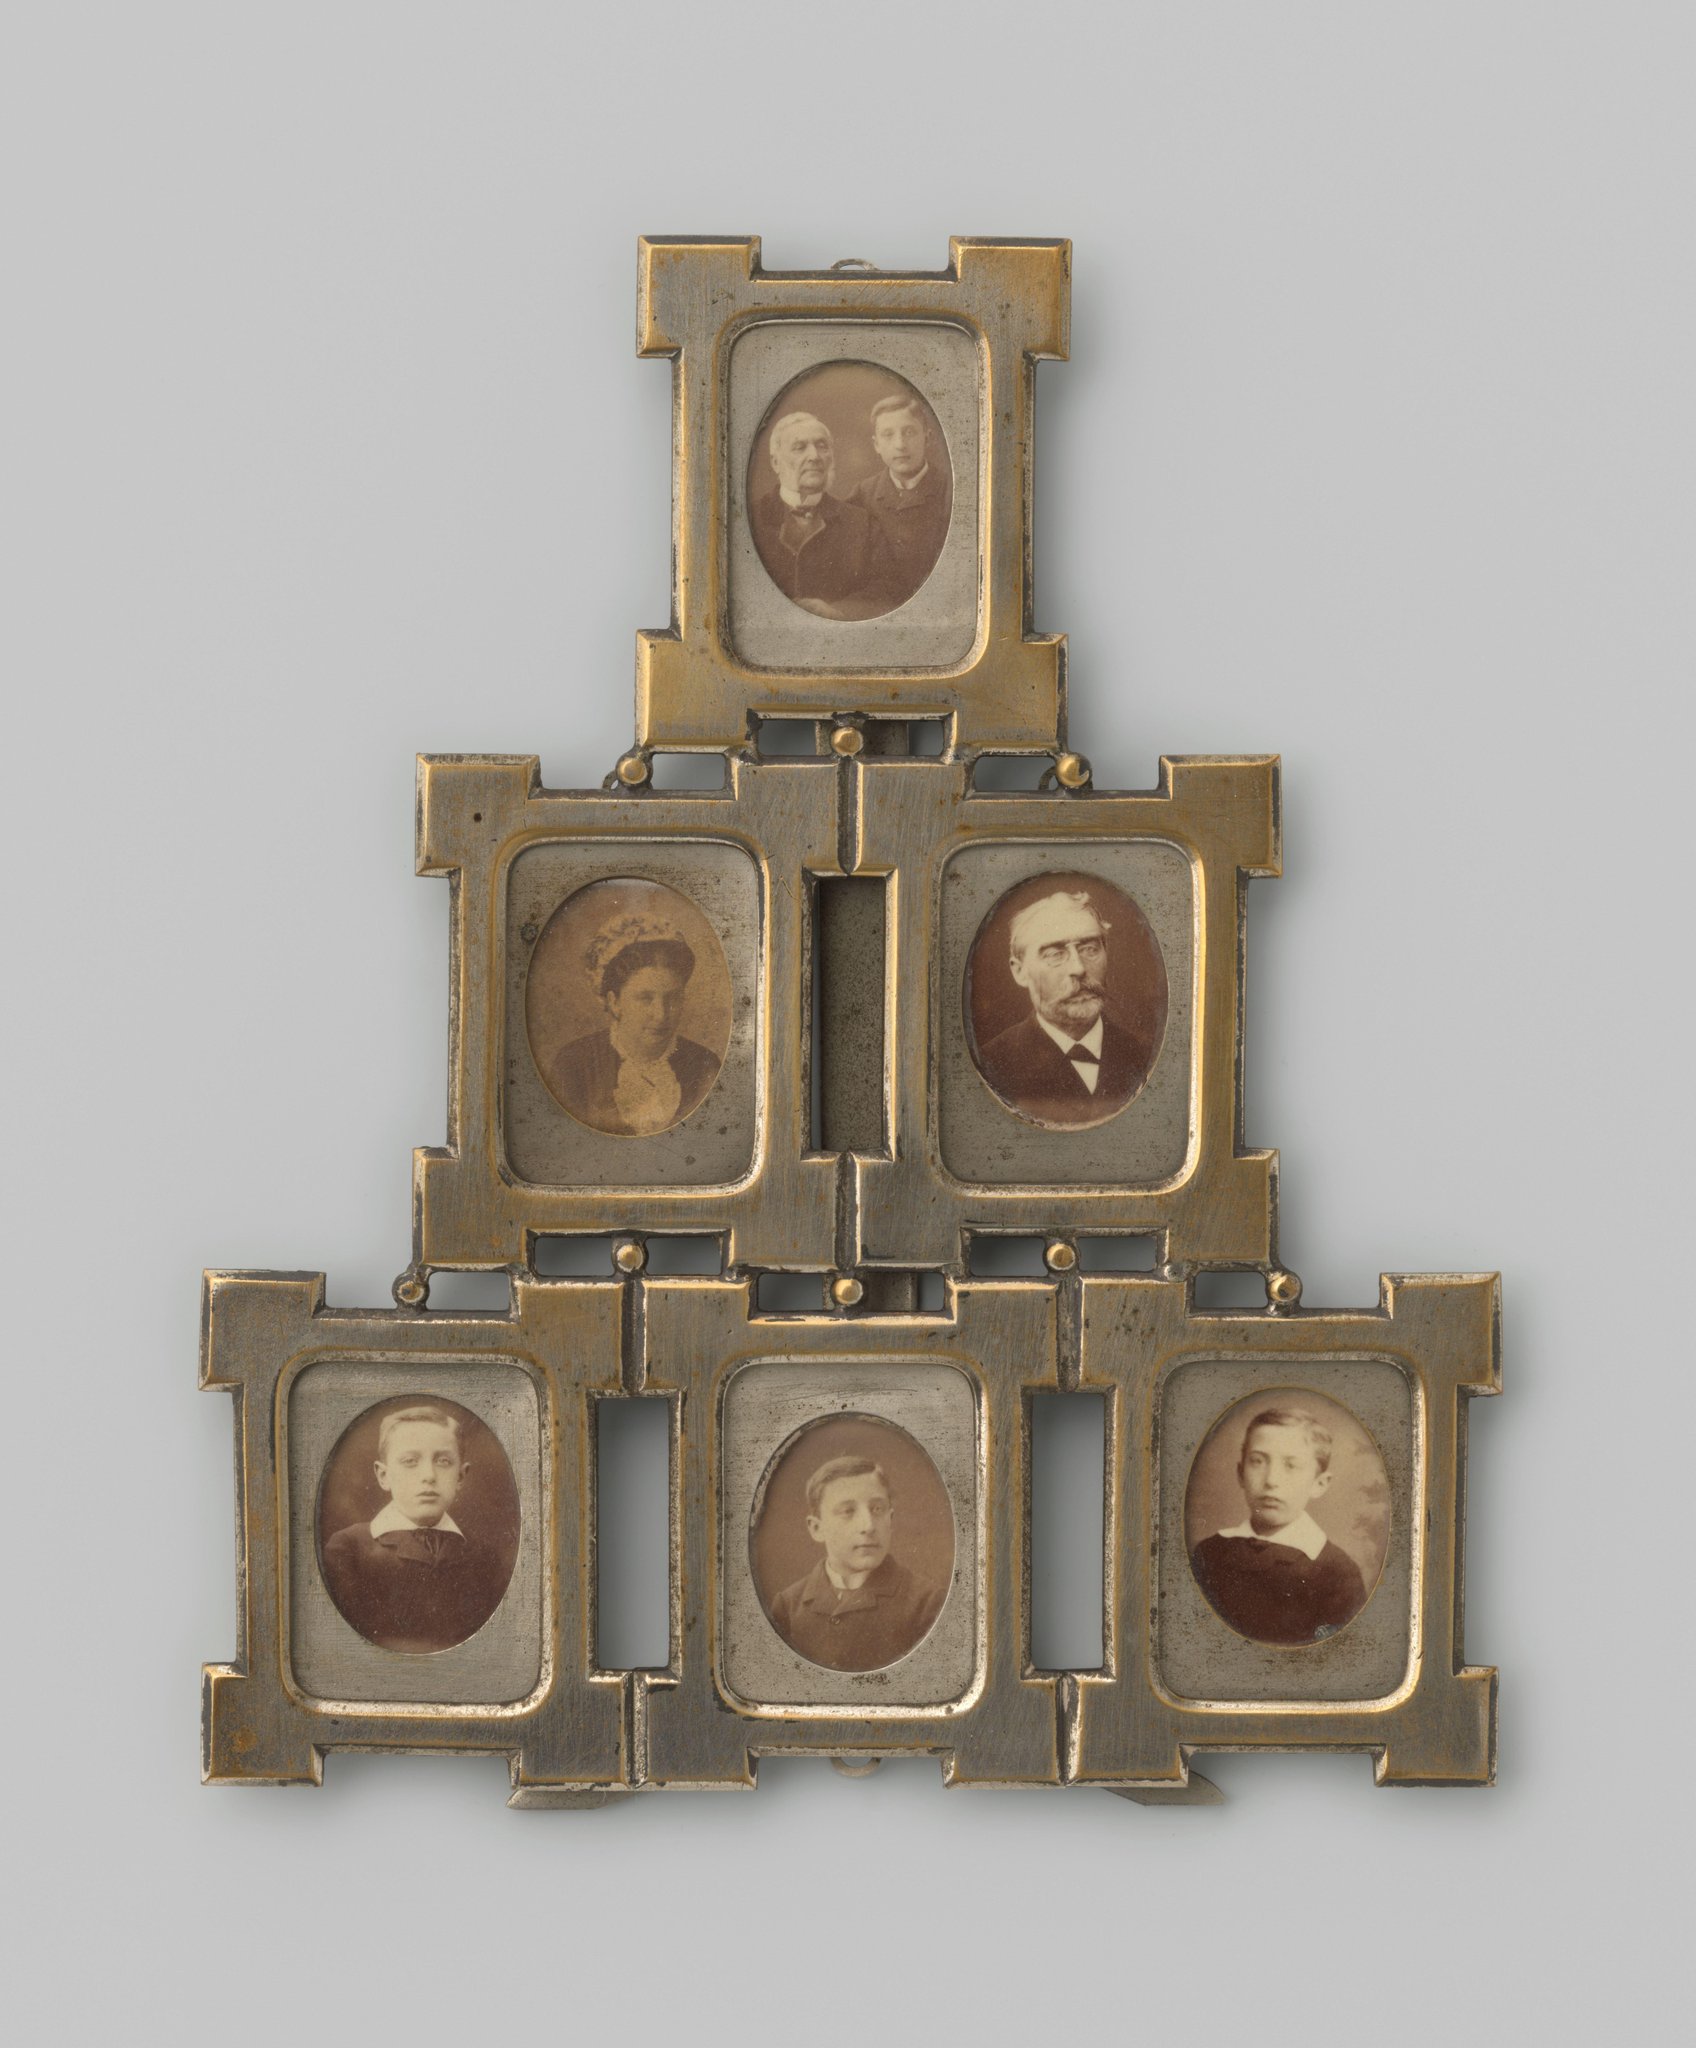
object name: photograph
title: Zes portretten van onbekende personen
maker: Anonymous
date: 1880-1900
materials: paper, glass, metal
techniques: albumen print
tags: anonymous historical person portrayed, three generations (family group)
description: De portretten zitten in een piramidevormige lijst.